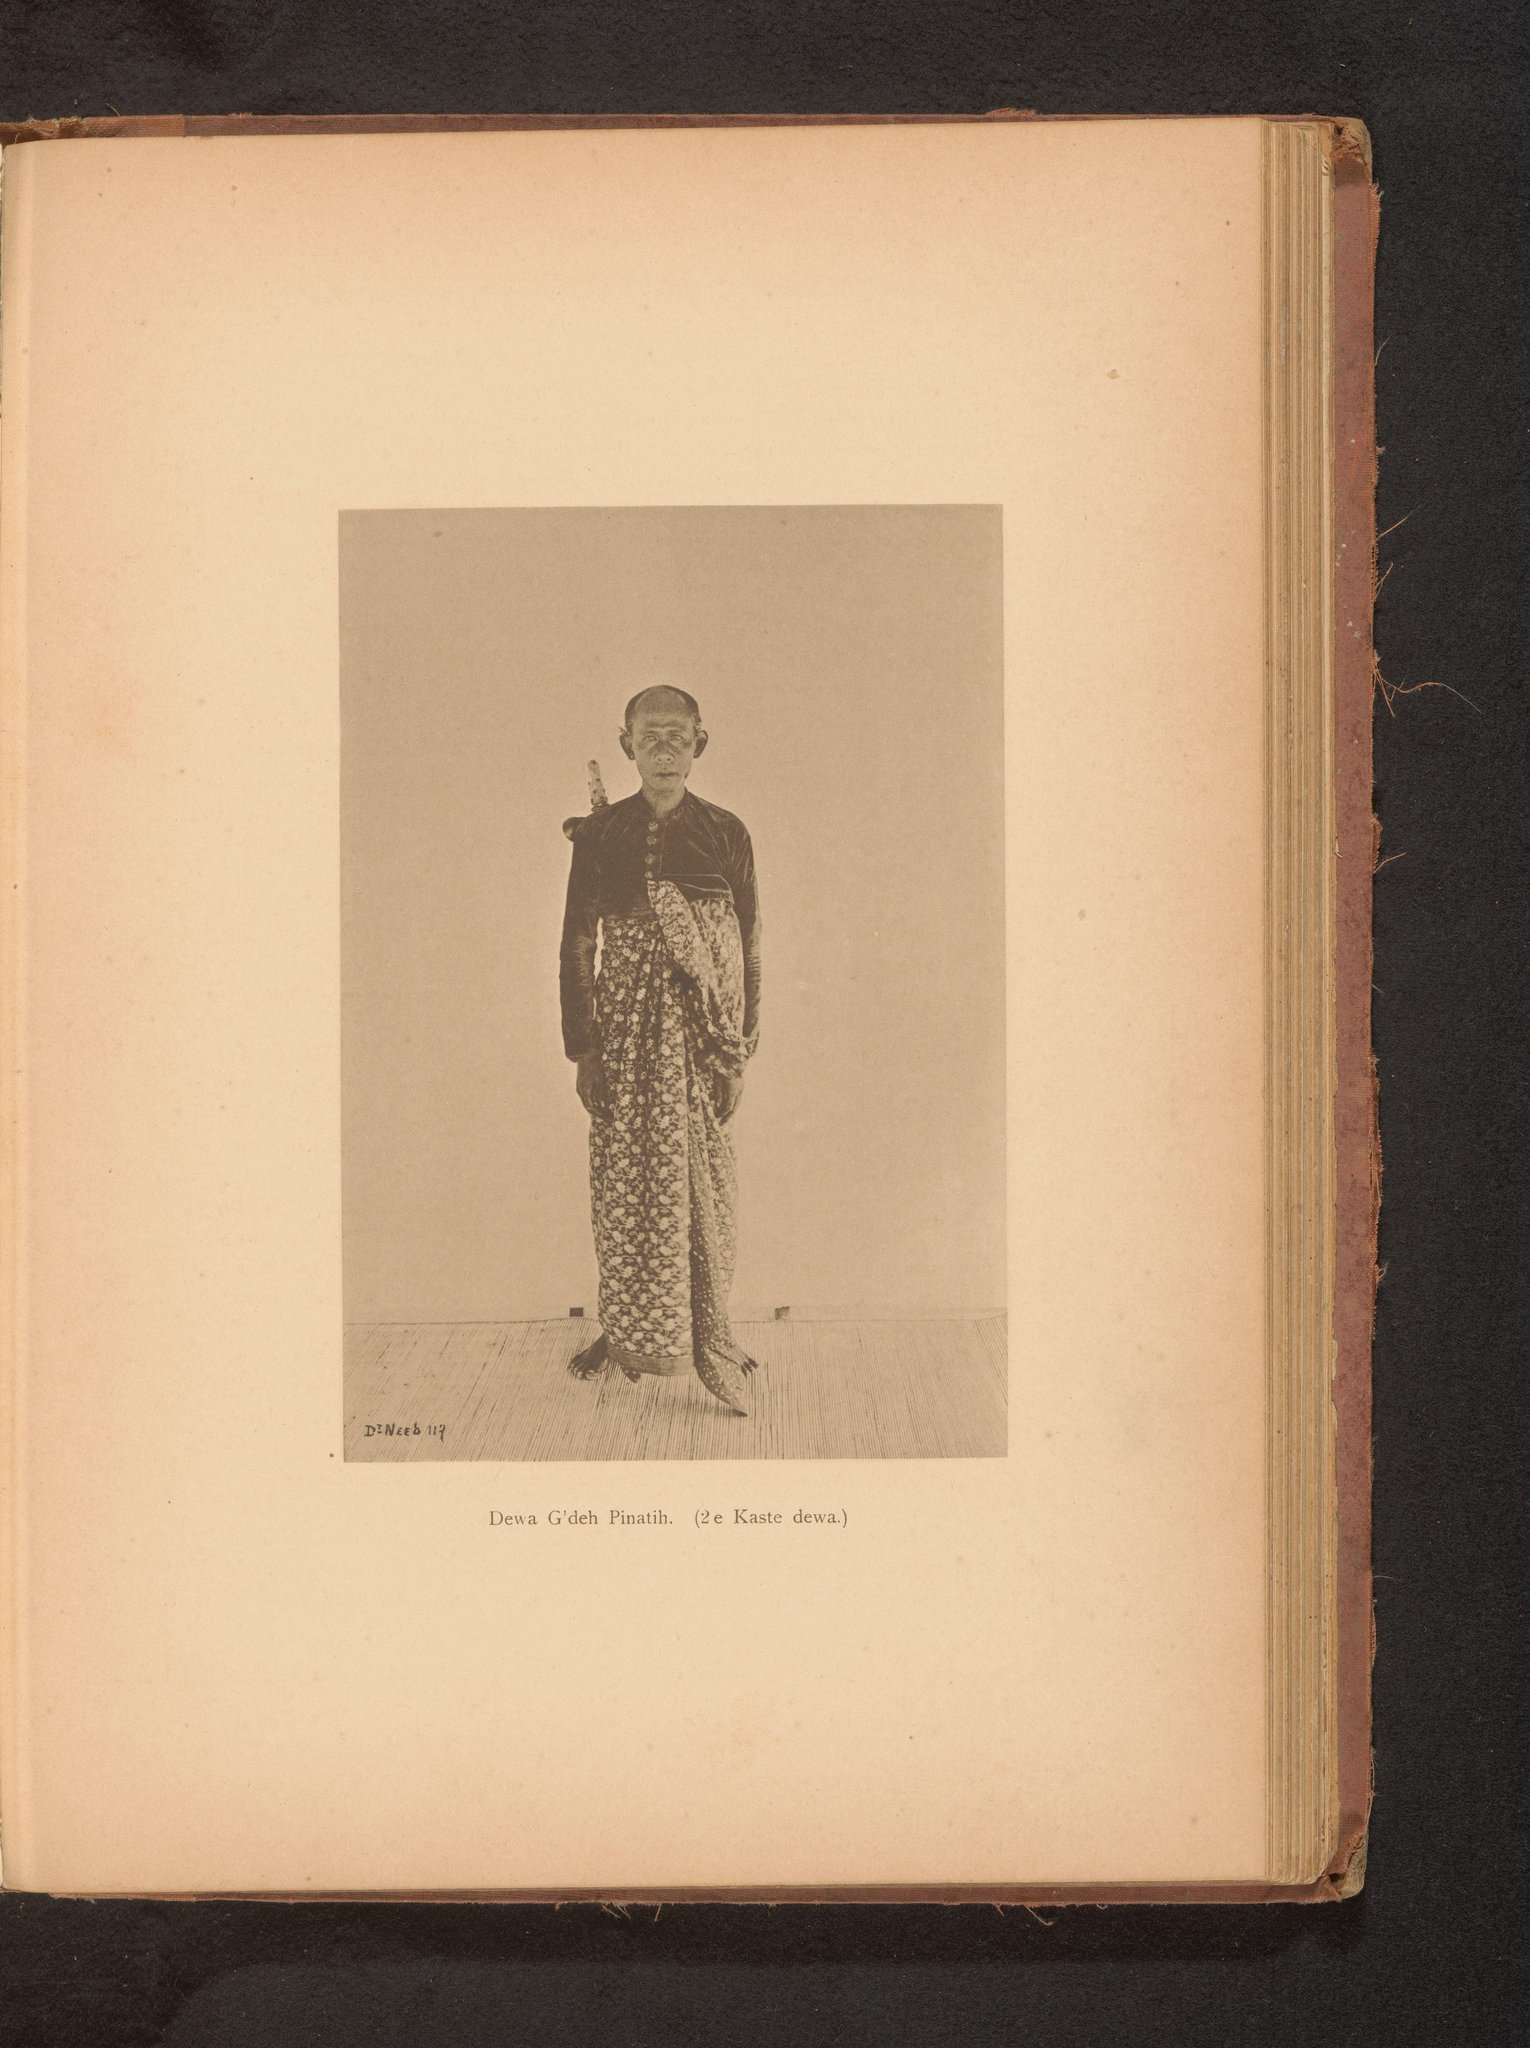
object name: page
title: Dewa G'deh Pinatih (2e Kaste dewa)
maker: christiaan johan neeb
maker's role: arts, fotograaf, officier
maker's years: 1860-1925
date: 1892-1897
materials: paper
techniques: photograph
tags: adult man, historical persons, indonesia